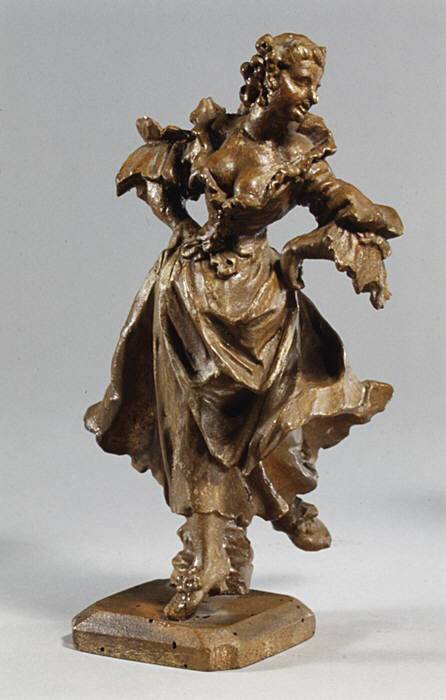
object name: statuette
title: Dancer and flute player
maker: ferdinand tietz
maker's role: artist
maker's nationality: austrian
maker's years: 1708-1777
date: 1734-1766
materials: gilt, wood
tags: men,women,flutes,dancers